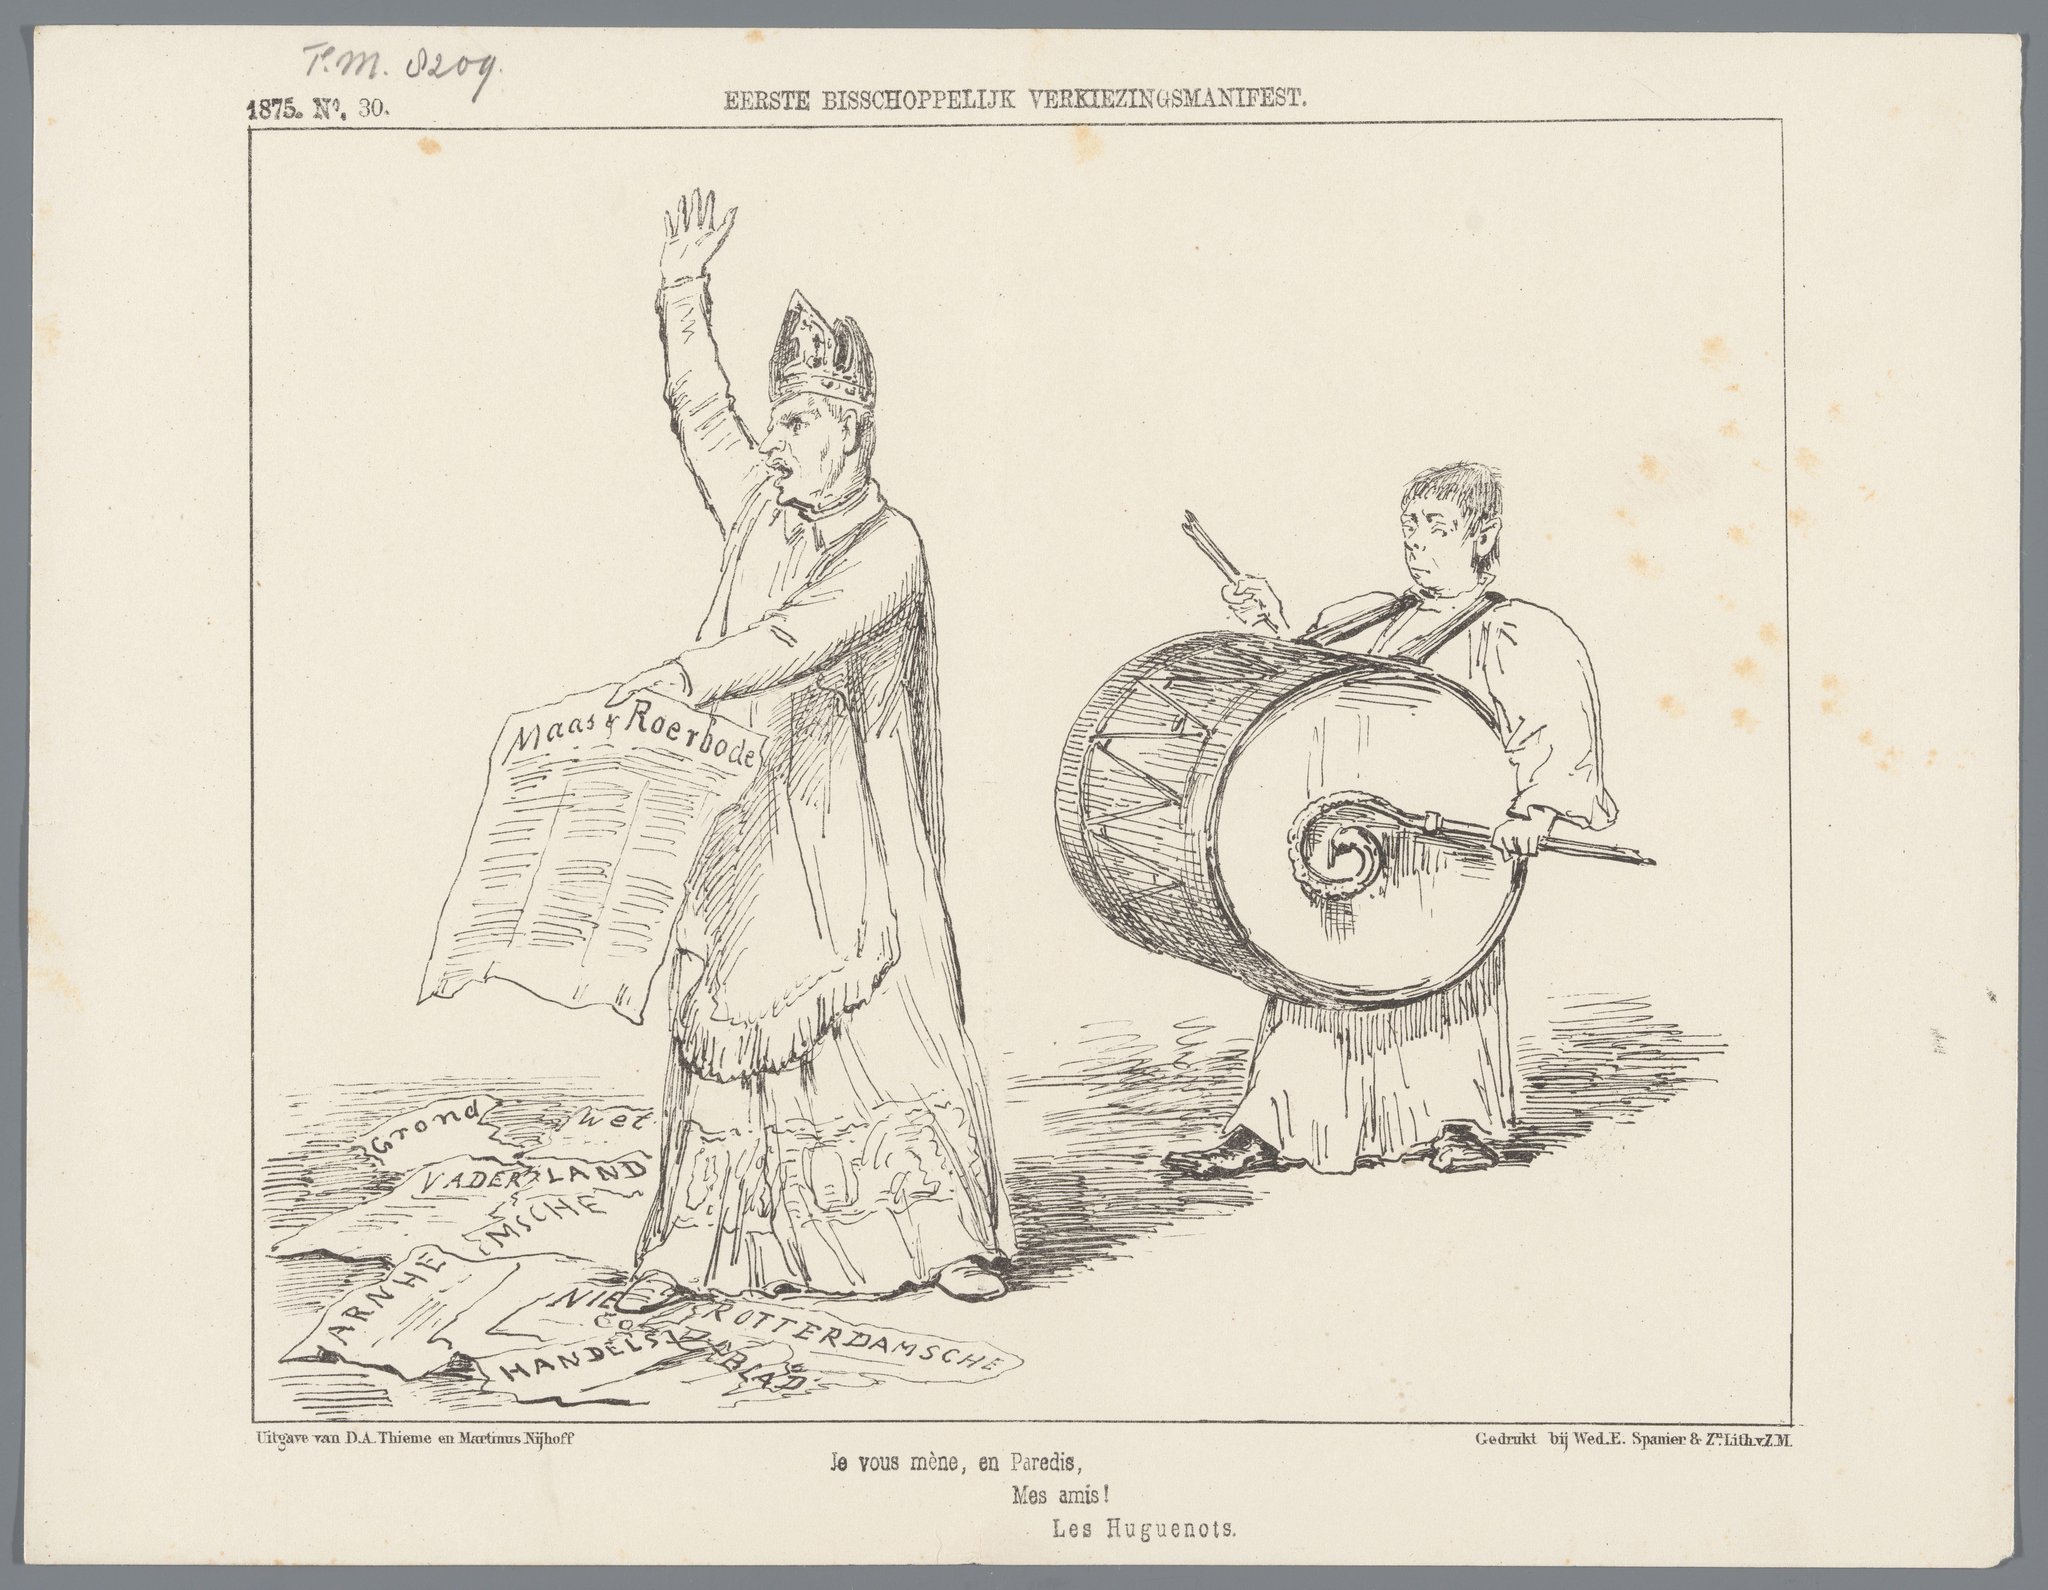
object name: cartoon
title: Spotprent waarin een bisschop de liberale dagbladen vertrapt, 1875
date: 1875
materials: paper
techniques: lithograph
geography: netherlands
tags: newspaper, news-sheet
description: Spotprent waarin een bisschop (van Roermond?) met de nieuwe courant 'Maas- en Roerbode' in de hand de liberale dagbladen vertrapt, 1875 . Plaat verschenen bij het weekblad De Nederlandsche Spectator, nr. 30, 1875.